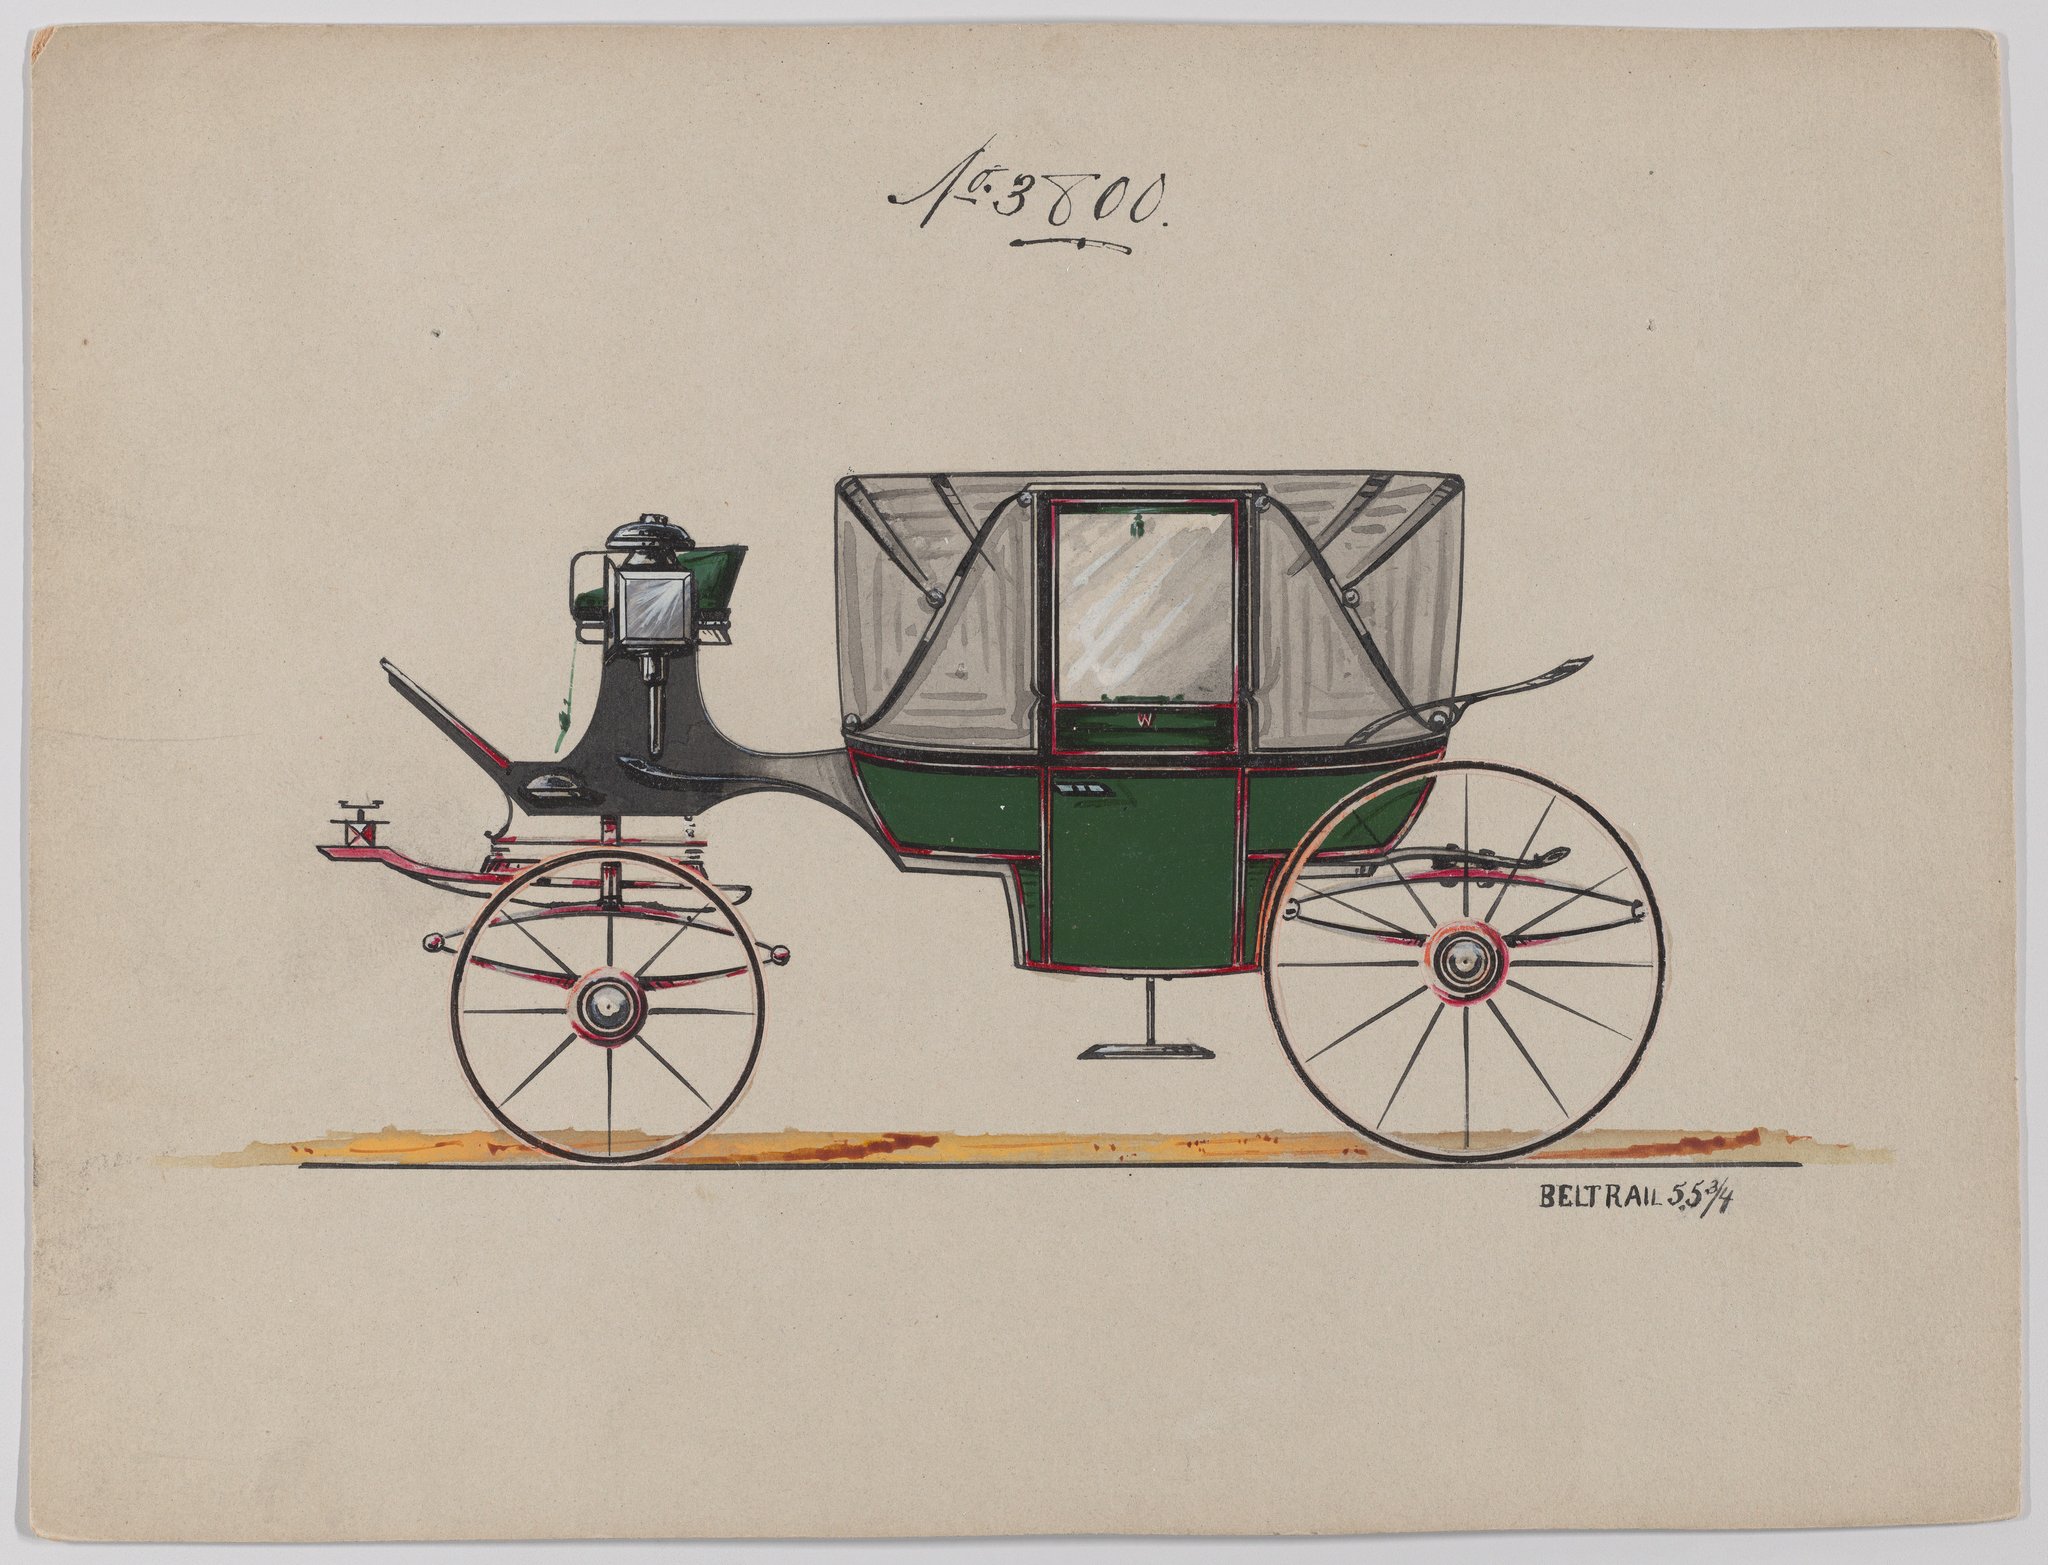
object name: drawing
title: Design for Landau, No. 3800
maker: brewster & co.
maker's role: manufacturer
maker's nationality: american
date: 1883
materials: gouache, gum arabic, ink, watercolor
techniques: pen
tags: carriages